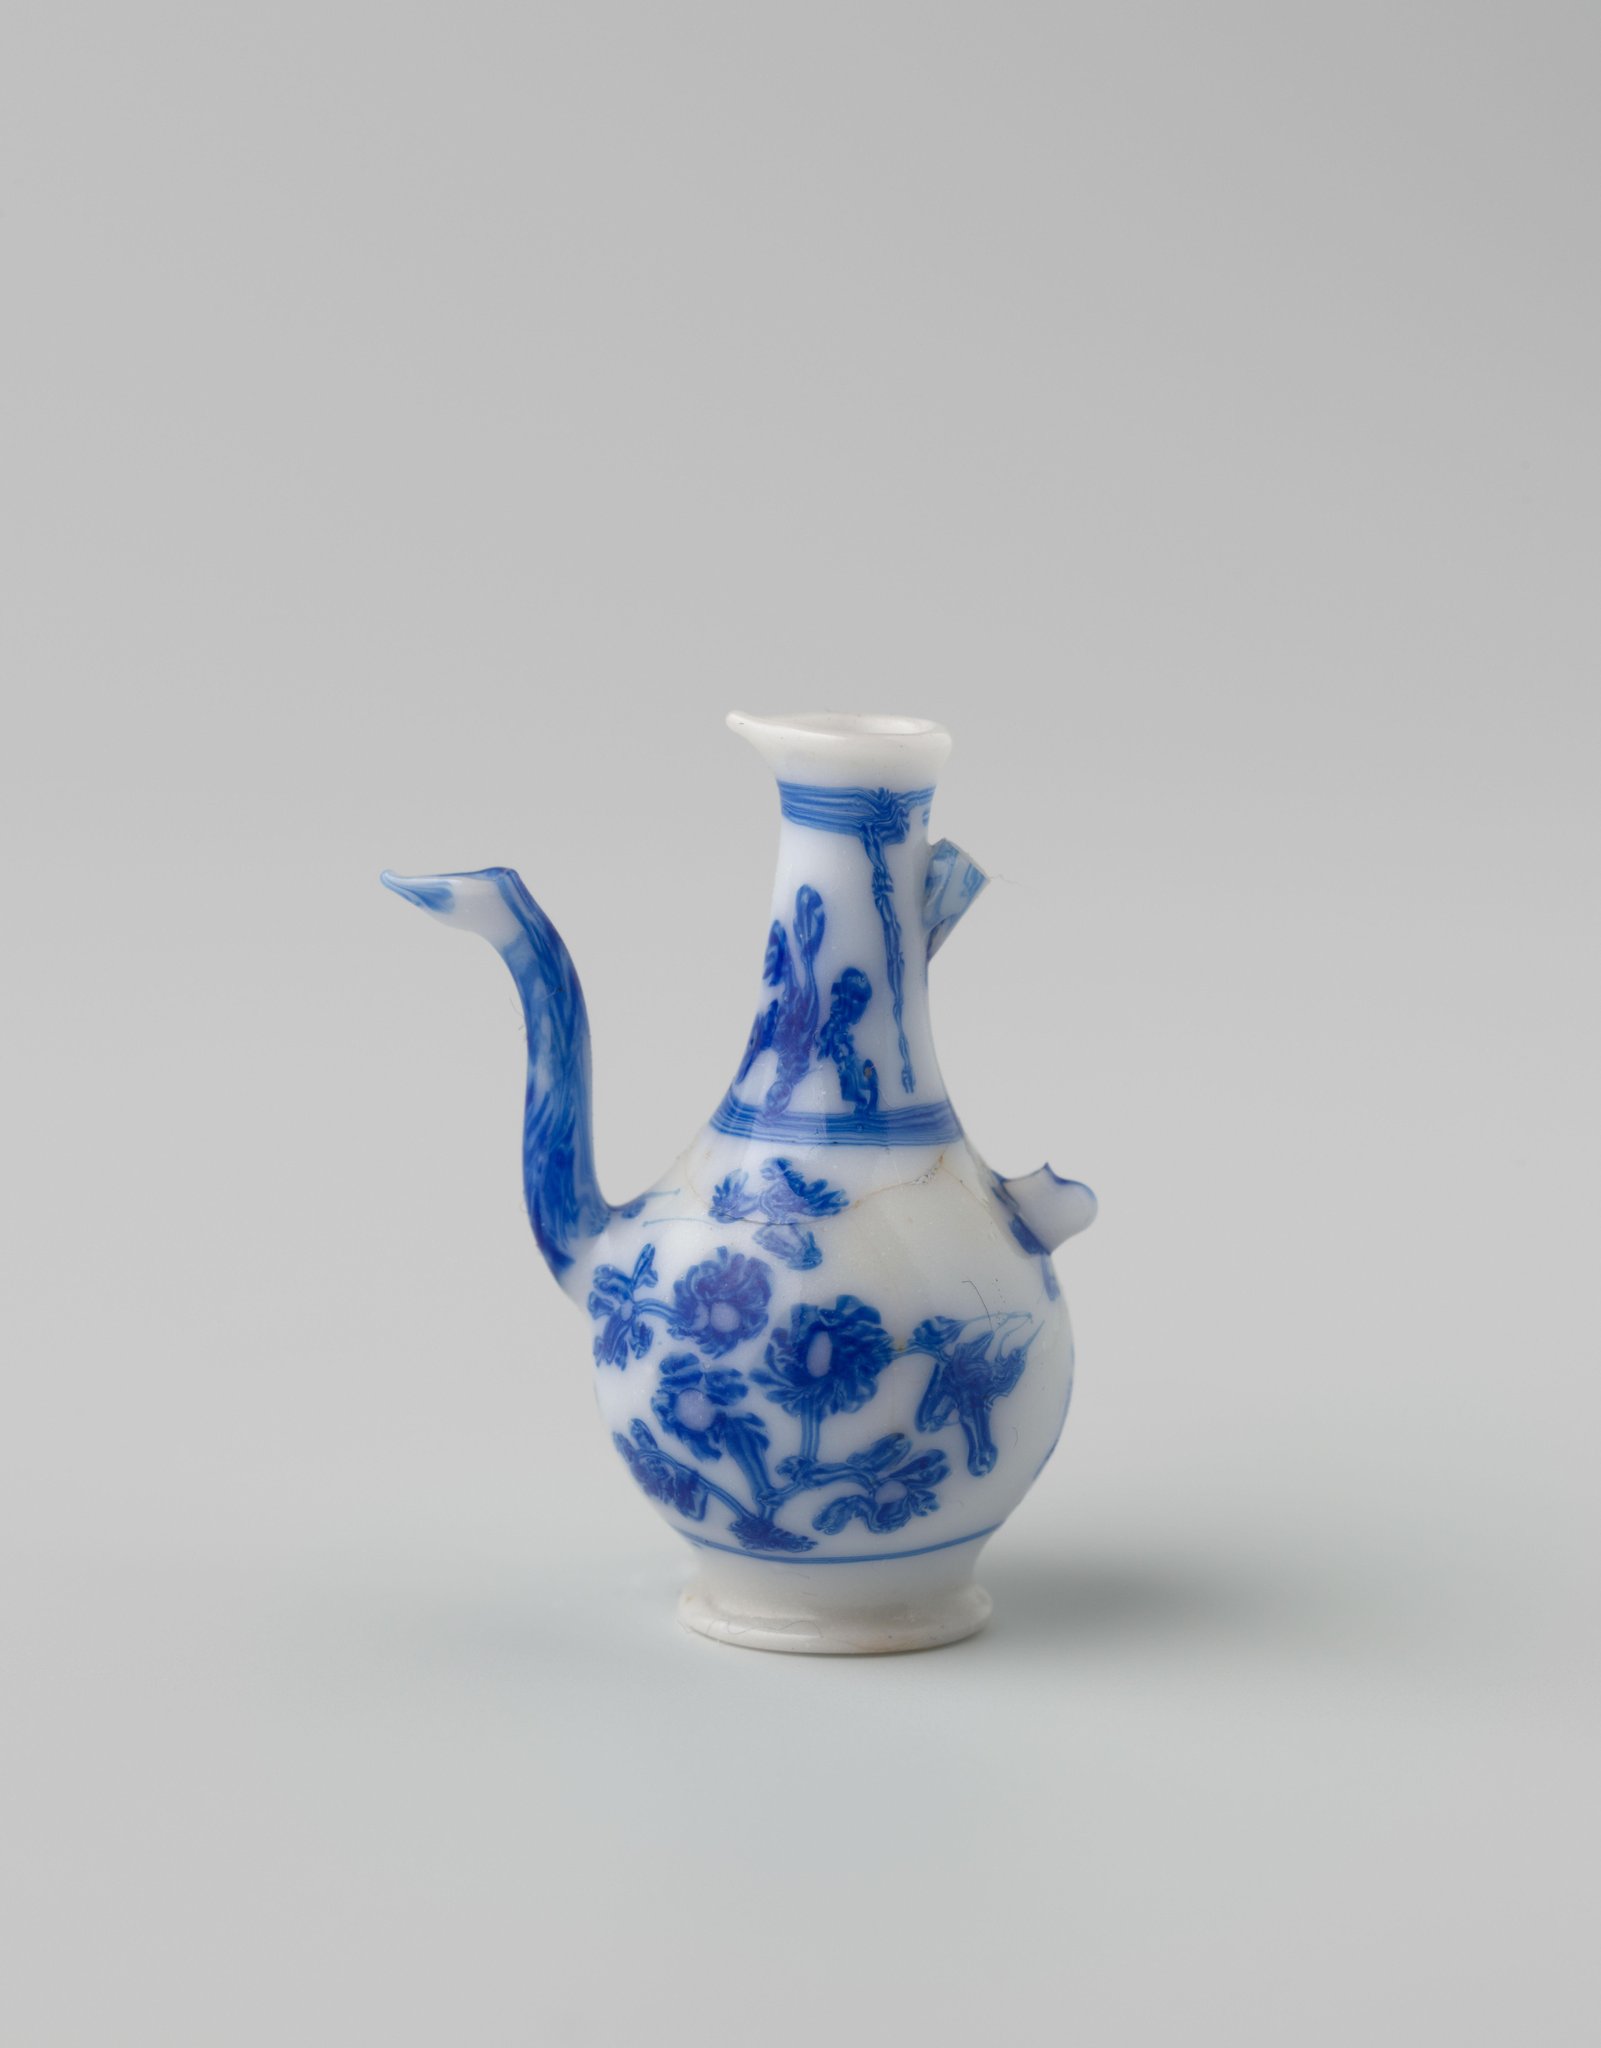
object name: ewer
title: Kan van melkglas met blauwe emailverf beschildering, imitatie Chinees porselein; decoratie van twee bloemtakken op de buik en bloemen in twee vakken op de hals. Peervormig.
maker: Anonymous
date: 1675-1710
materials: glass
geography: amsterdam